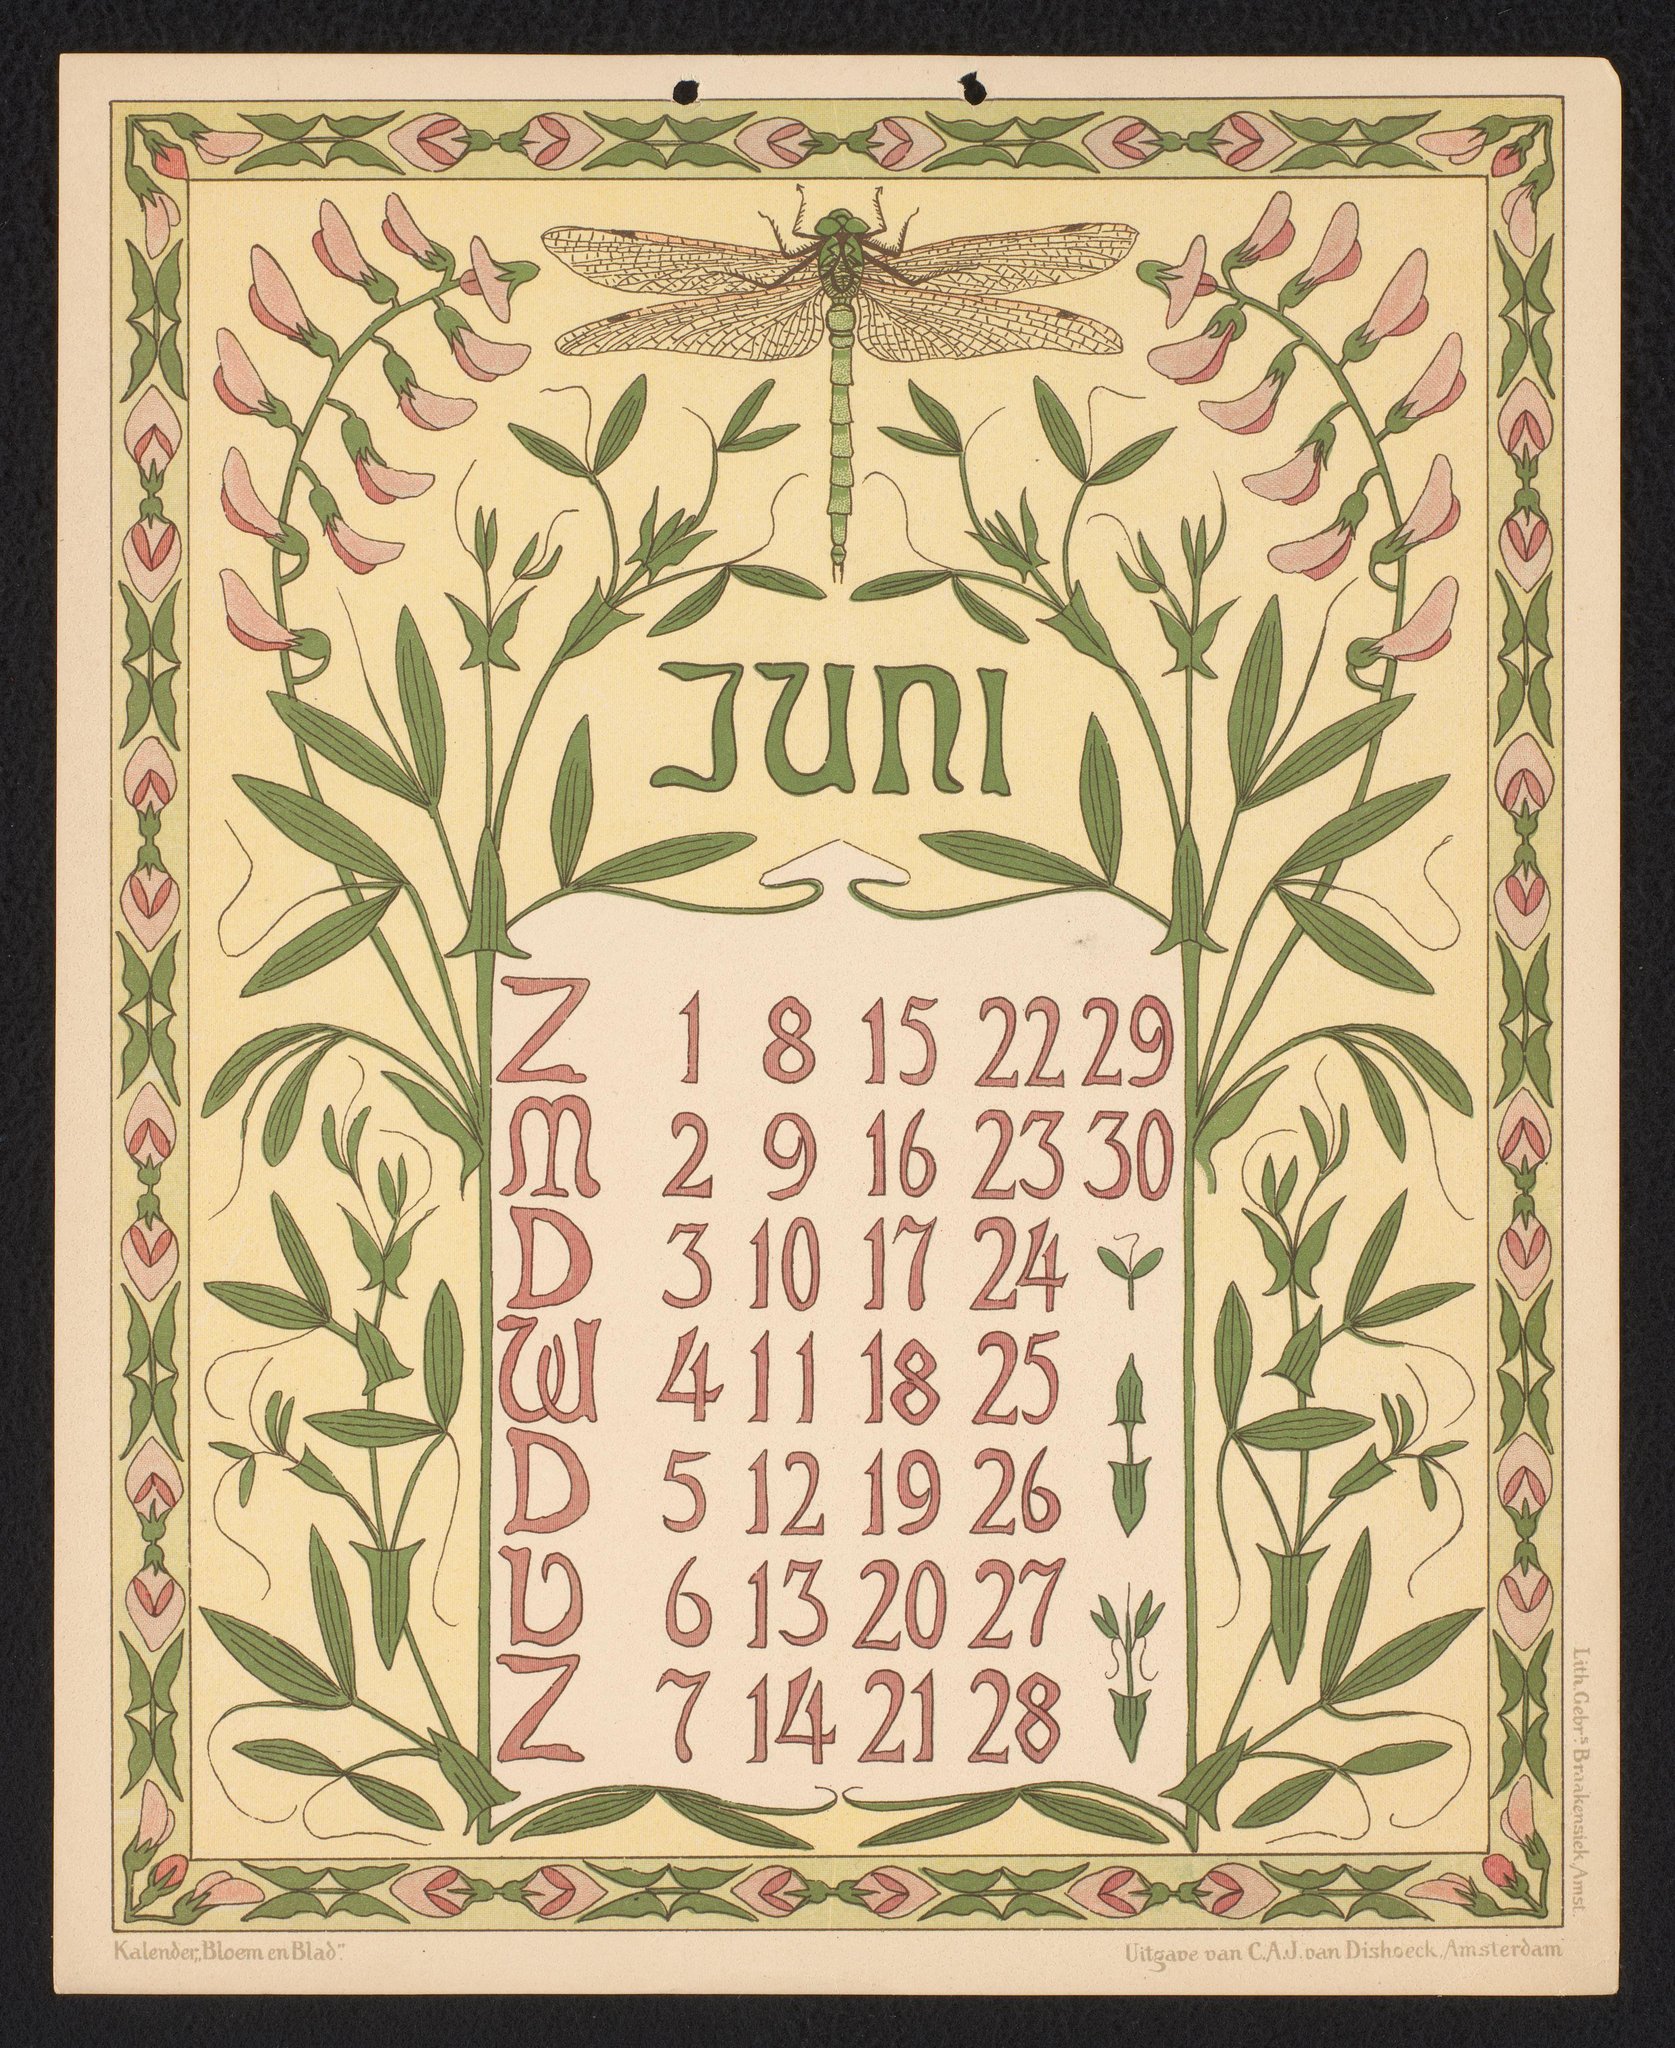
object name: calendar leaf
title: Kalenderblad voor juni 1902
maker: c.a.j. van dishoeck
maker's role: publisher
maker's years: 1863-1931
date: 1901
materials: paper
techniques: lithograph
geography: amsterdam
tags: flowers, ornaments ~ art, calendar, almanac, insects: dragon-fly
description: Kalenderblad voor juni 1902 van de kalender 'Bloem en Blad', met een randdecoratie van planten en een libelle.